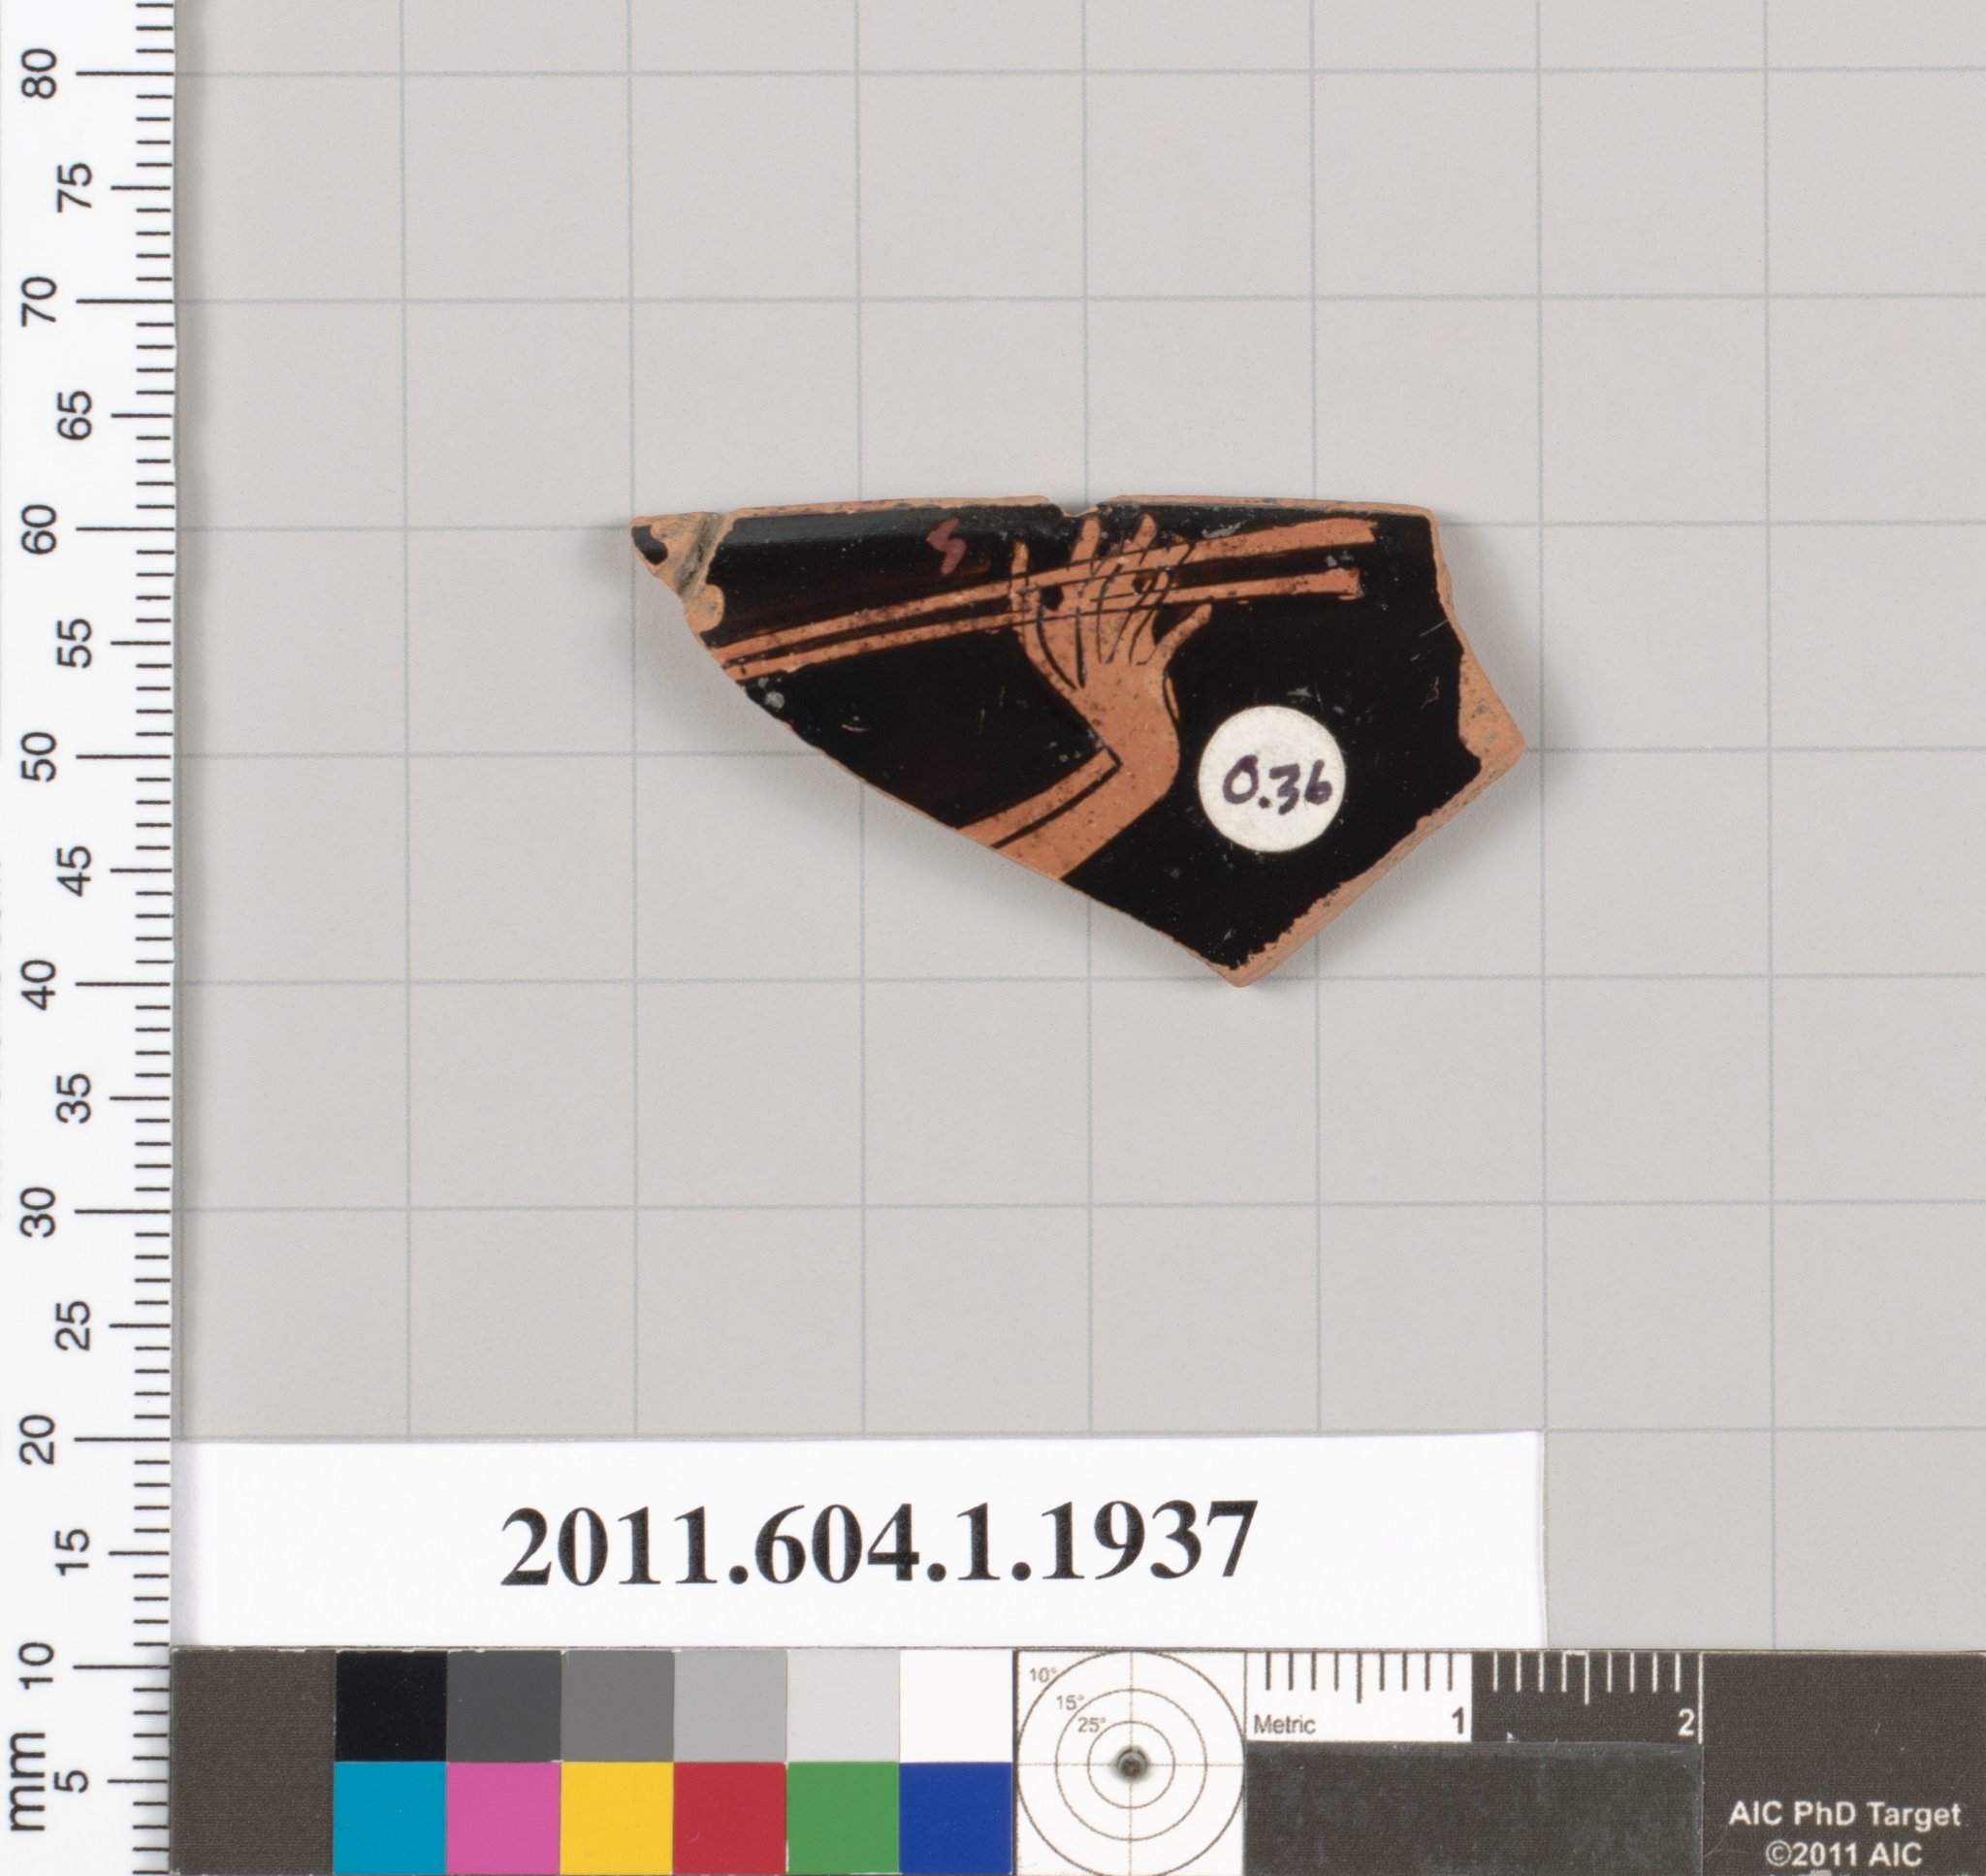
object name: kylix fragment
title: Terracotta rim fragment of a kylix (drinking cup)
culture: greek, attic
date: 490-480 BCE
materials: terracotta